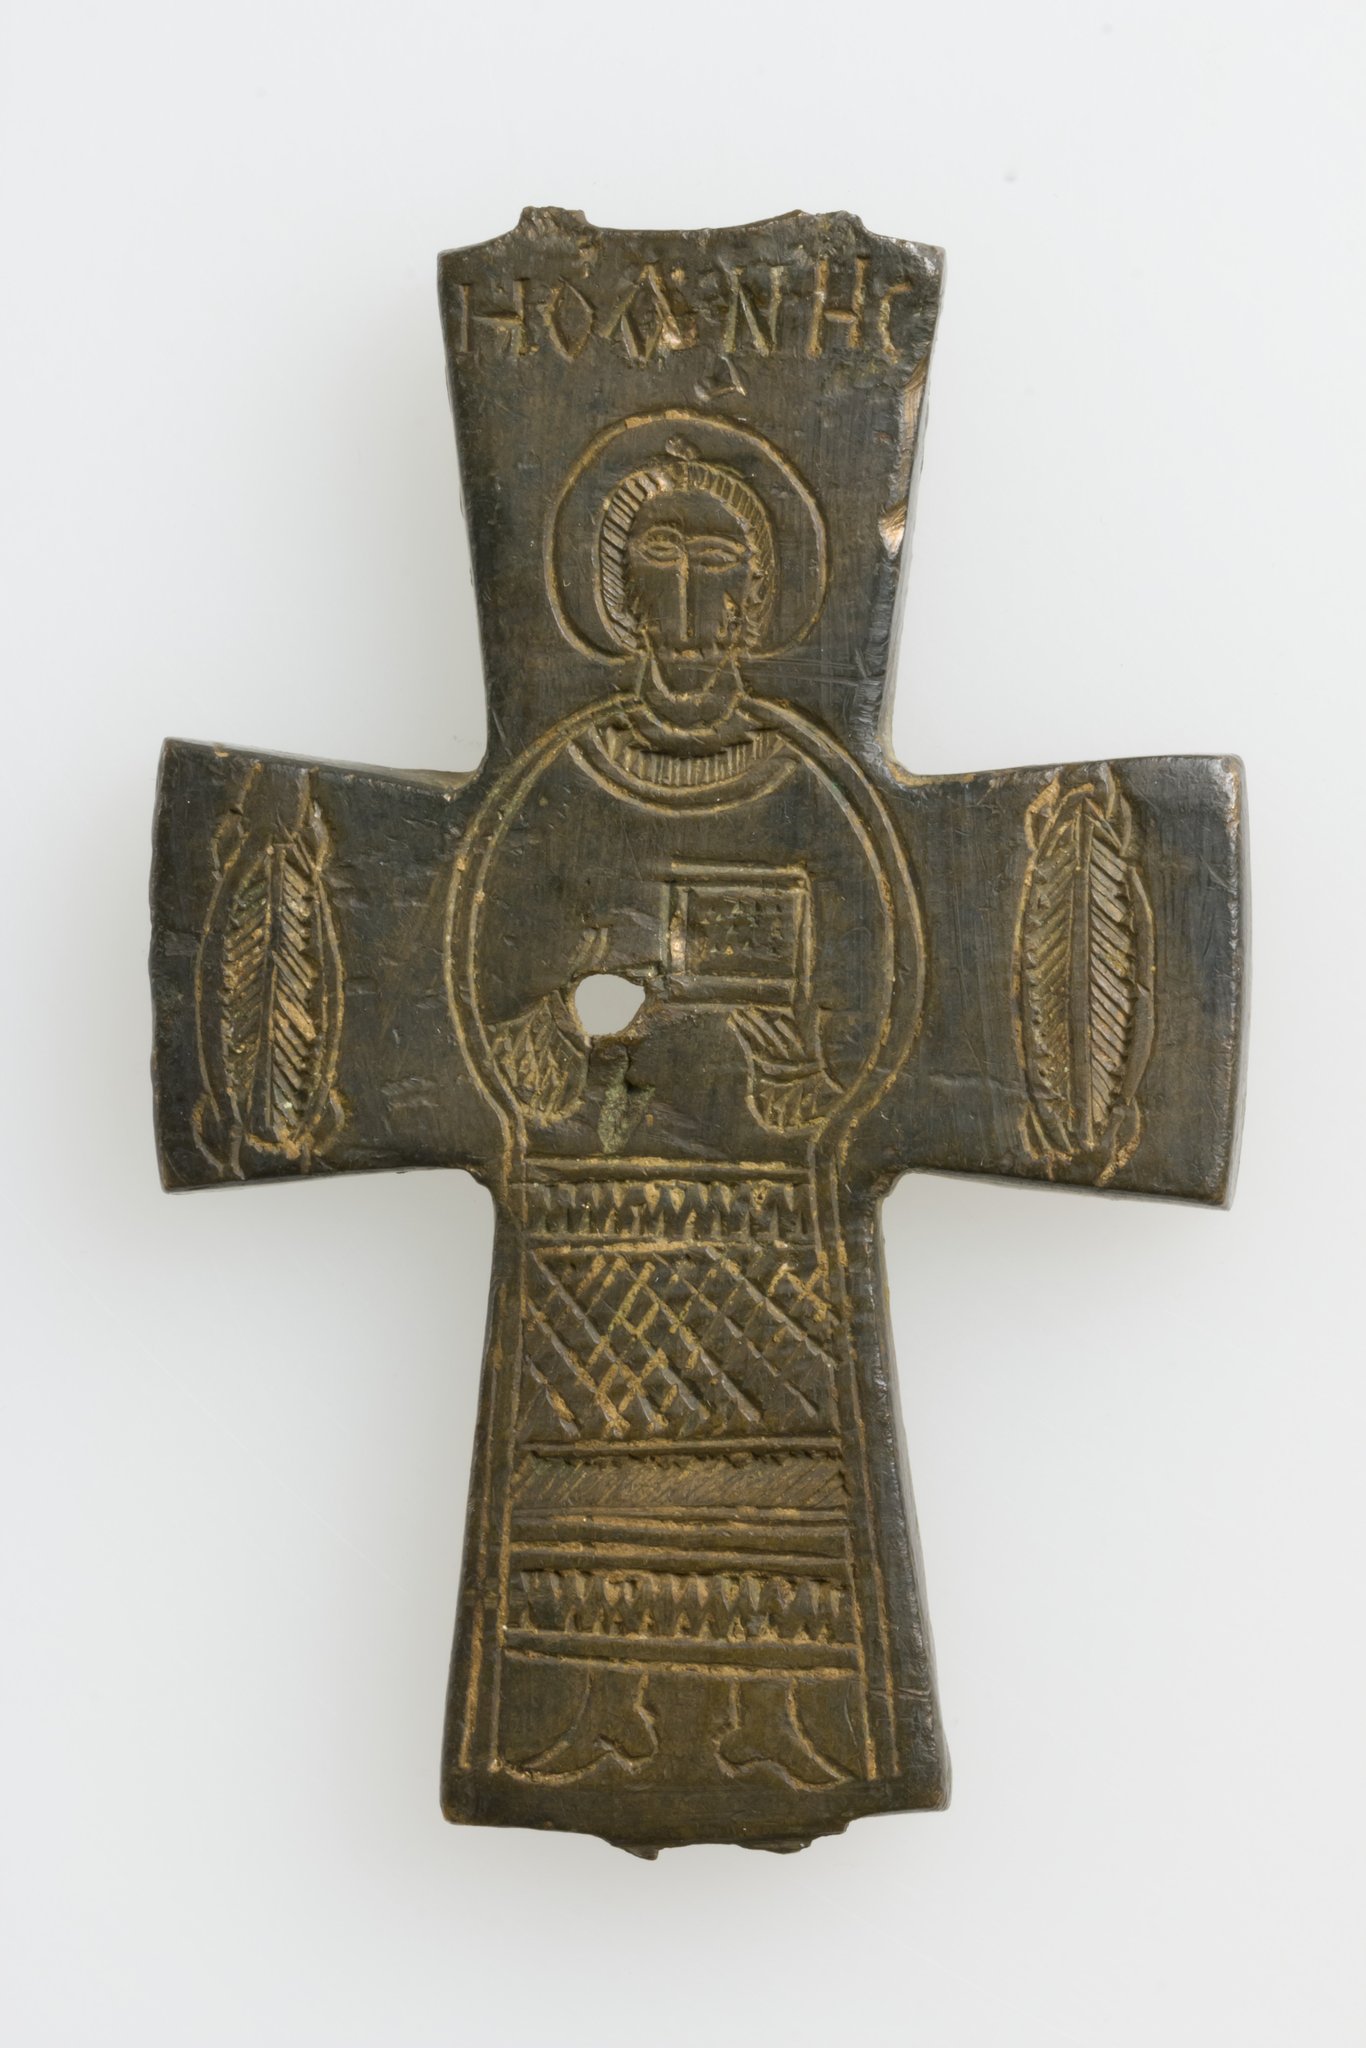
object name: reliquary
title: Half of a Reliquary Pendant Cross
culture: byzantine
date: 1001-1100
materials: copper alloy